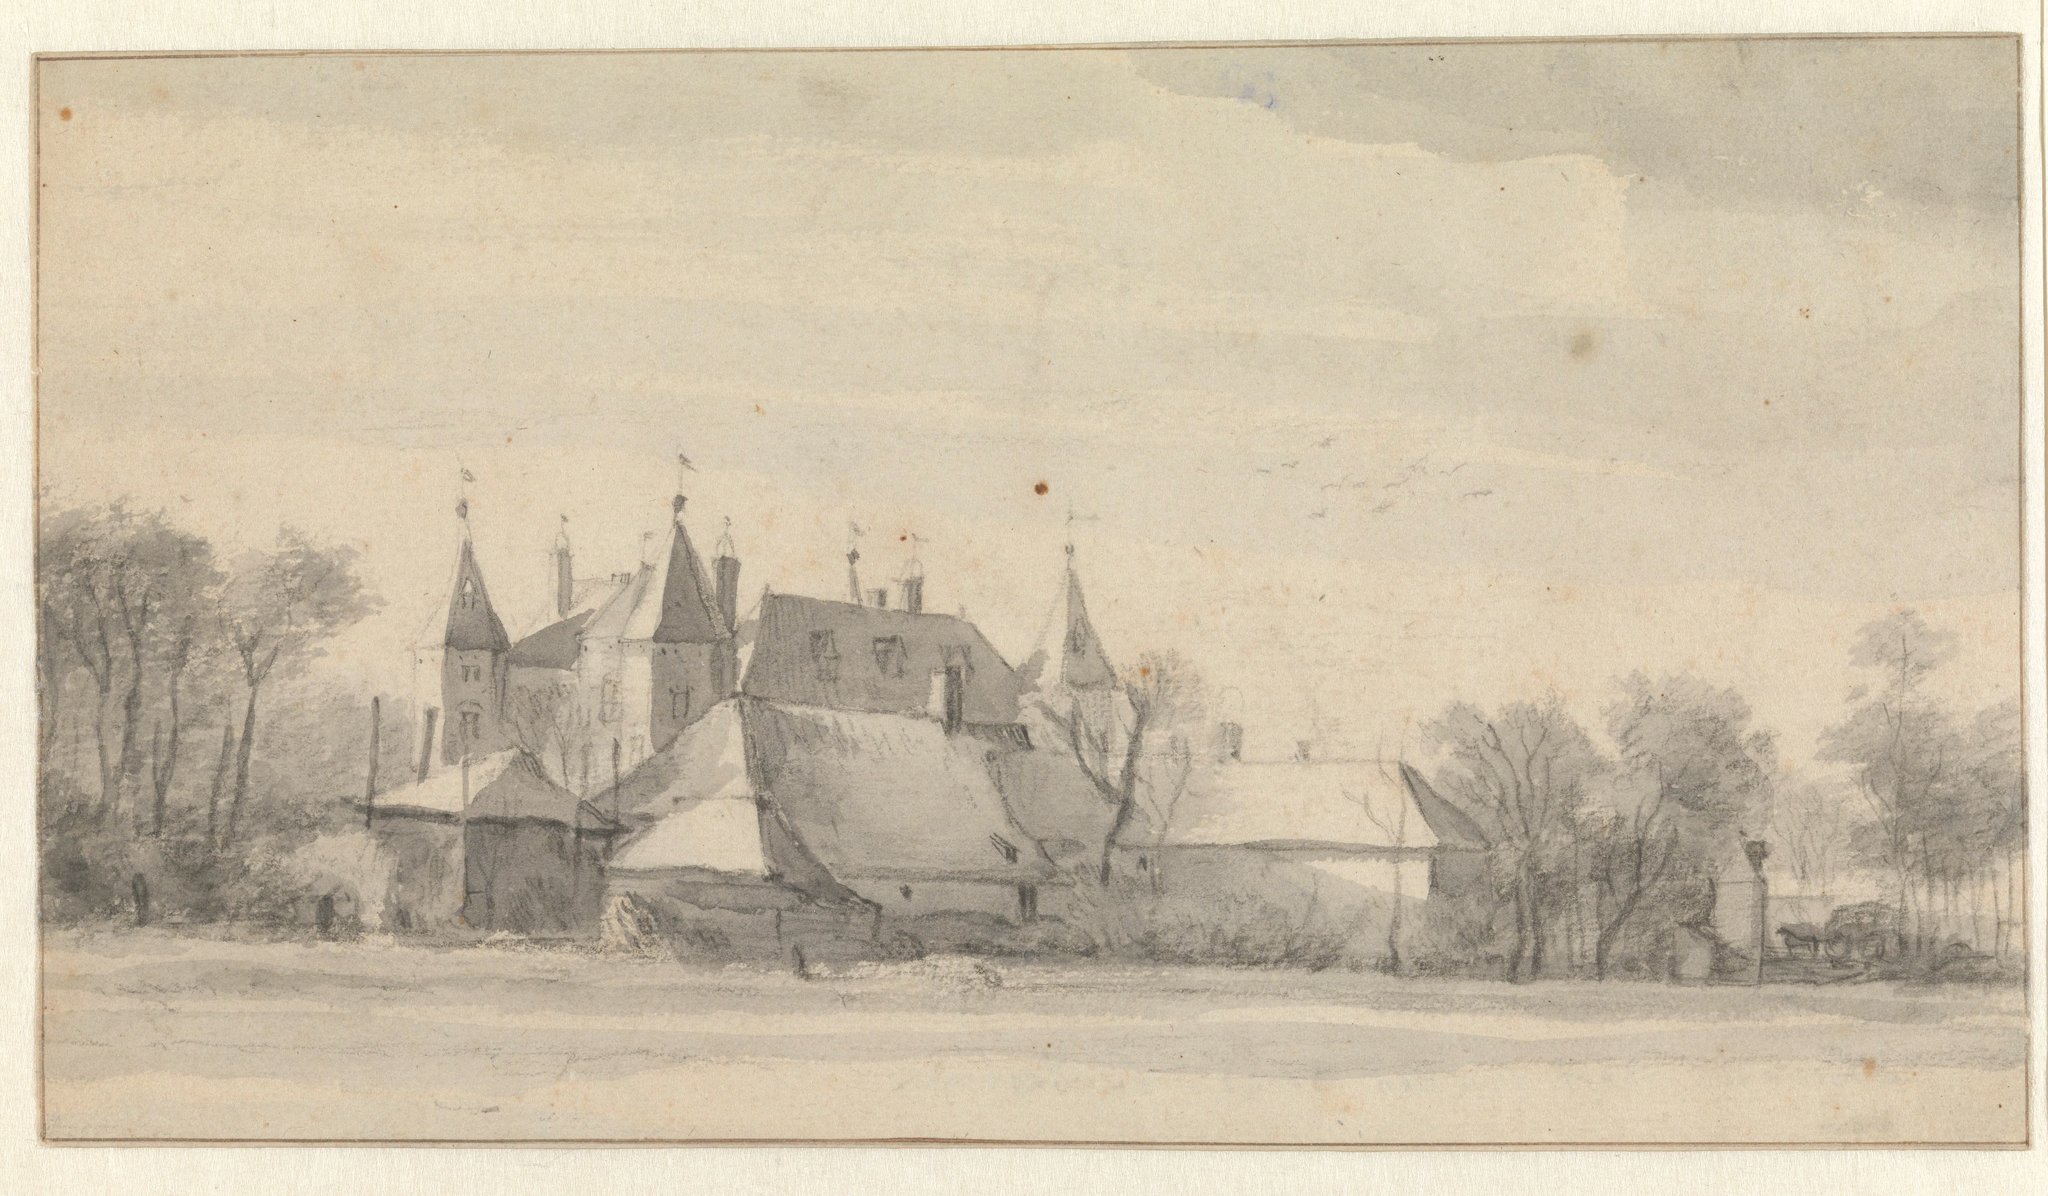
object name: drawing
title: The village of Nederhorst and the castle from the south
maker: roelant roghman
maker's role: draughtsman, painter, print maker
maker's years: 1627-1692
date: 1646-1647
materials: chalk, ink, paper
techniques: brush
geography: nederhorst den berg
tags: castle, nederhorst den berg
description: Roghman created a picturesque portrayal of Nederhorst, the church and castle, and a carriage making its way across the bridge right up to the gate. The drawing’s original panoramic character became clear when this sheet was reunited with the recently gifted right half. It was not unusual for art dealers to cut drawings into separate pieces. Two or three individual drawings often fetched more than a single large one.